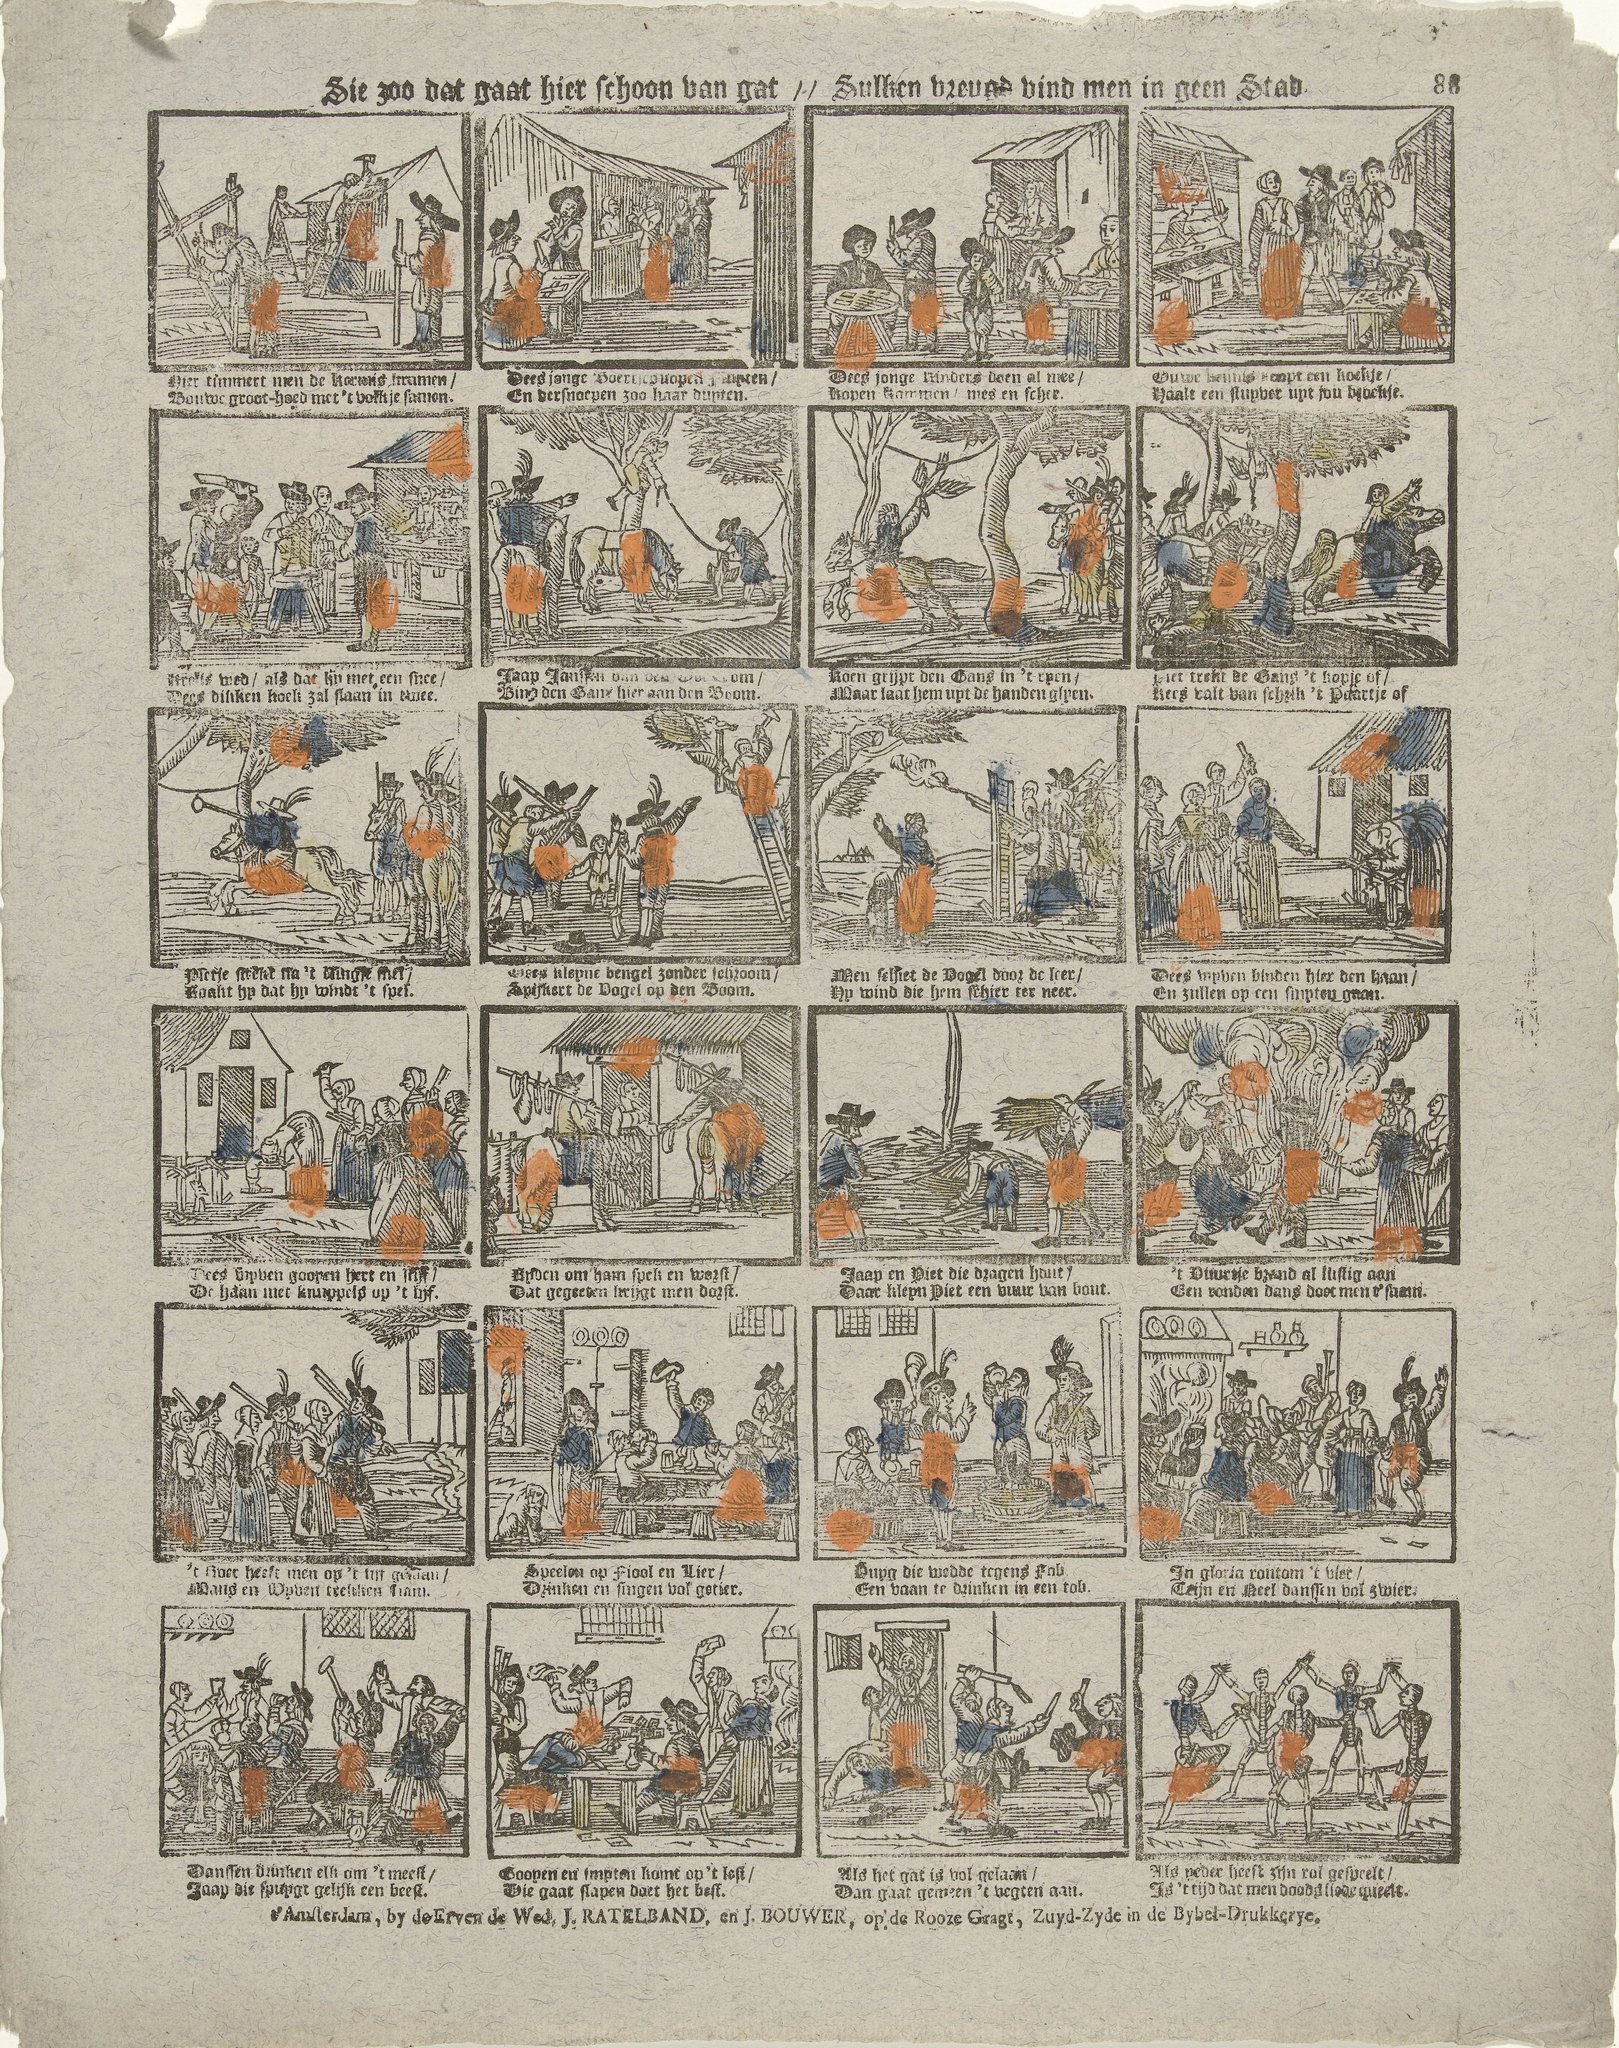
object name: popular print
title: Sie zoo dat gaat hier schoon van gat // Sulken vreugd vind men in geen Stad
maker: Anonymous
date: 1782-1793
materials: paper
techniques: colour, letterpress printing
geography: amsterdam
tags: (annual) fair, trade fair, pleasure fair and circus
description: Blad met 24 voorstellingen van de kermis. Onder elke afbeelding een tweeregelig vers. Genummerd rechtsboven: 88.